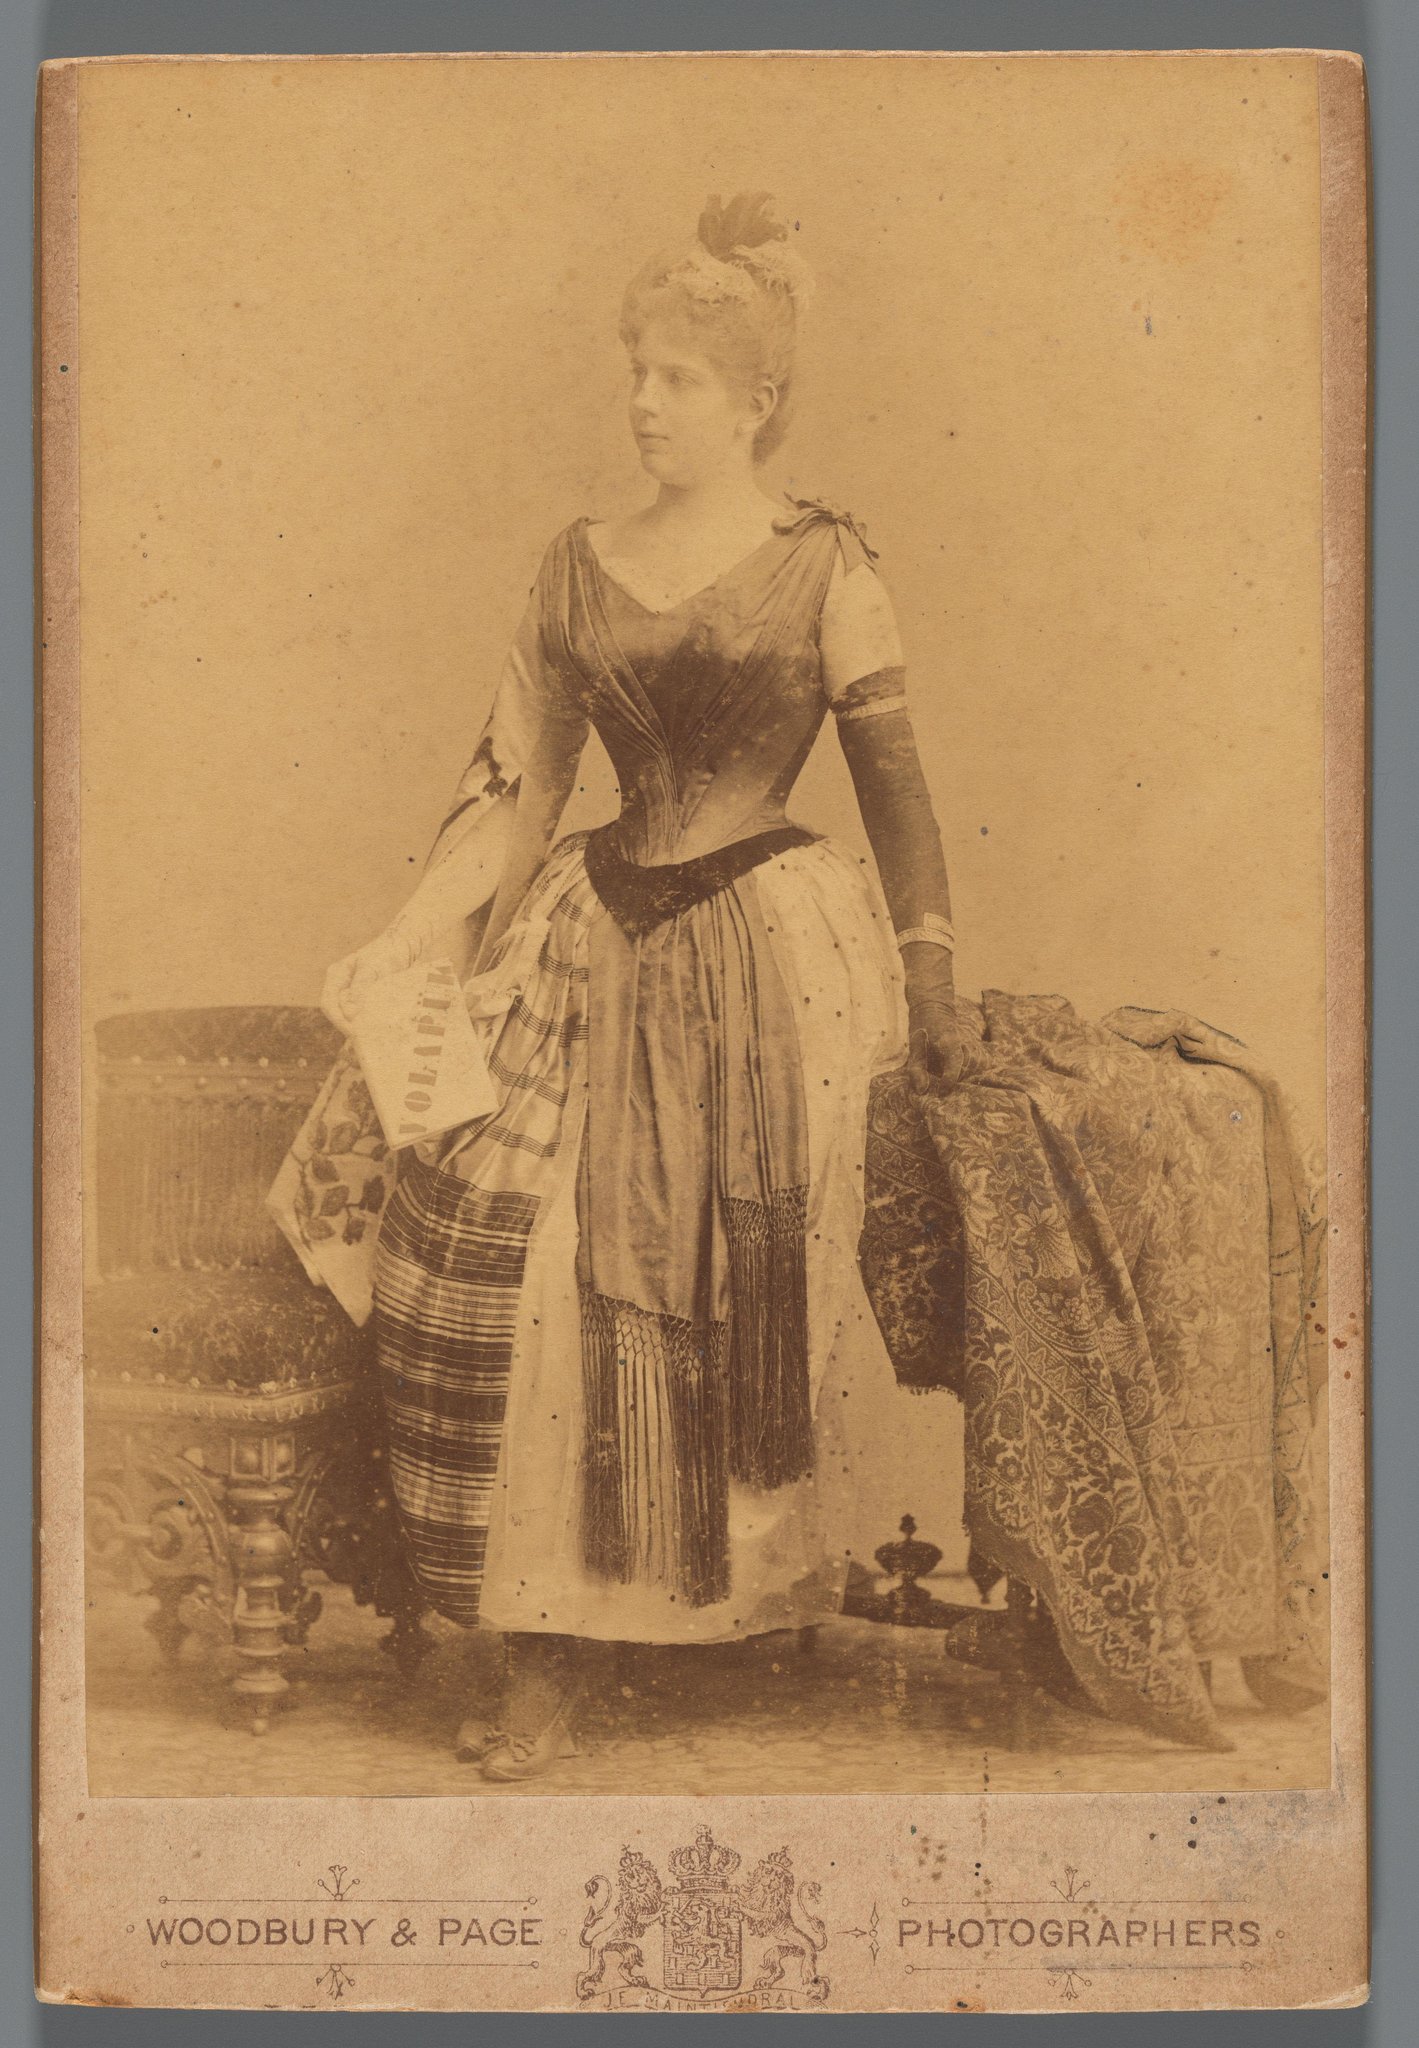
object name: cabinet photograph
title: Studioportret van Pauline van den Berg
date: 1870-1900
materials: cardboard, photographic support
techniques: albumen print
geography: java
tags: pauline wilhelmine louise blommestein-van den berg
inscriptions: inscription: ‘WOODBURY & PAGE PHOTOGRAPHERS’, name: ‘Pauline van den Berg’, name: ‘WOODBURY & PAGE / PHOTOGRAPHERS / JAVA.’